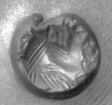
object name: stamp seal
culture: sasanian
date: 201-700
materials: gemstone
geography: iran or mesopotamia